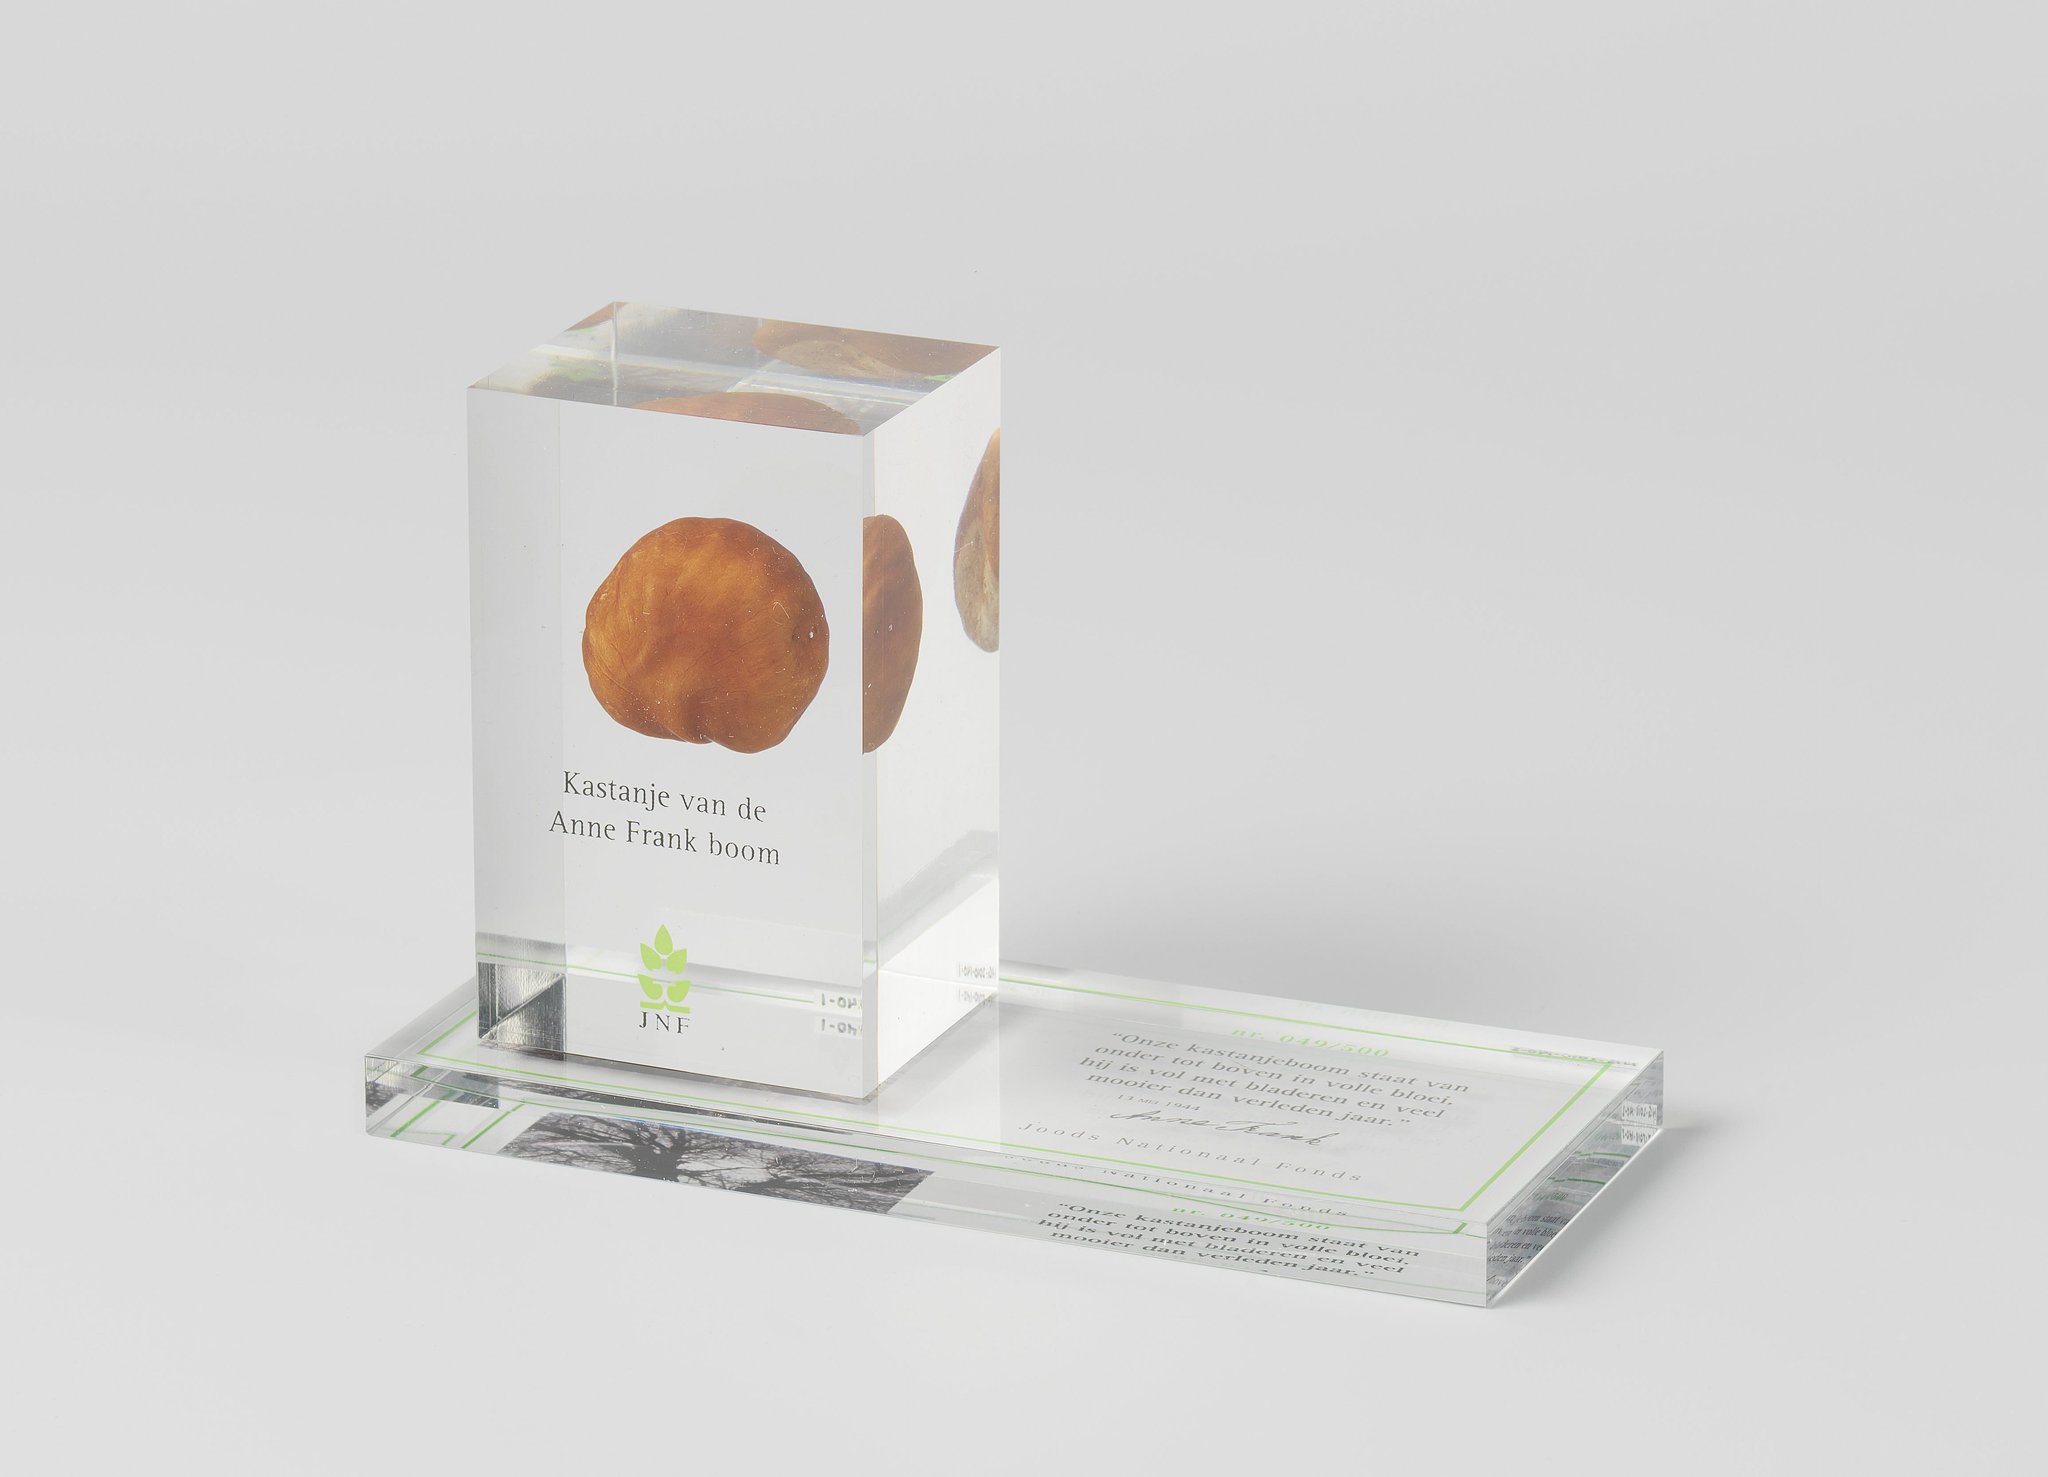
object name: commemorative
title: Kastanje van de Anne Frankboom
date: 2010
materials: wood, paper, plastic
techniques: casting, printing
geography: netherlands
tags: anne frank, fruits: chestnut, amsterdam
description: Kastanje, gegoten in een staand plexiglazen zuiltje. Op het plexiglas het opschrift: "Kastanje van de Anne Frank Boom" en het logo van het Joods Nationaal Fonds. Hierbij een platte rechthoekinge plaat van plexiglas met daarin een gedrukte afbeelding van de Anne Frankboom, een citaat uit het dagboek en de naam van Anne Frank. Hierbij een echtheidsverklaring. Het geheel in een grijs bedrukt kartonnen doosje.